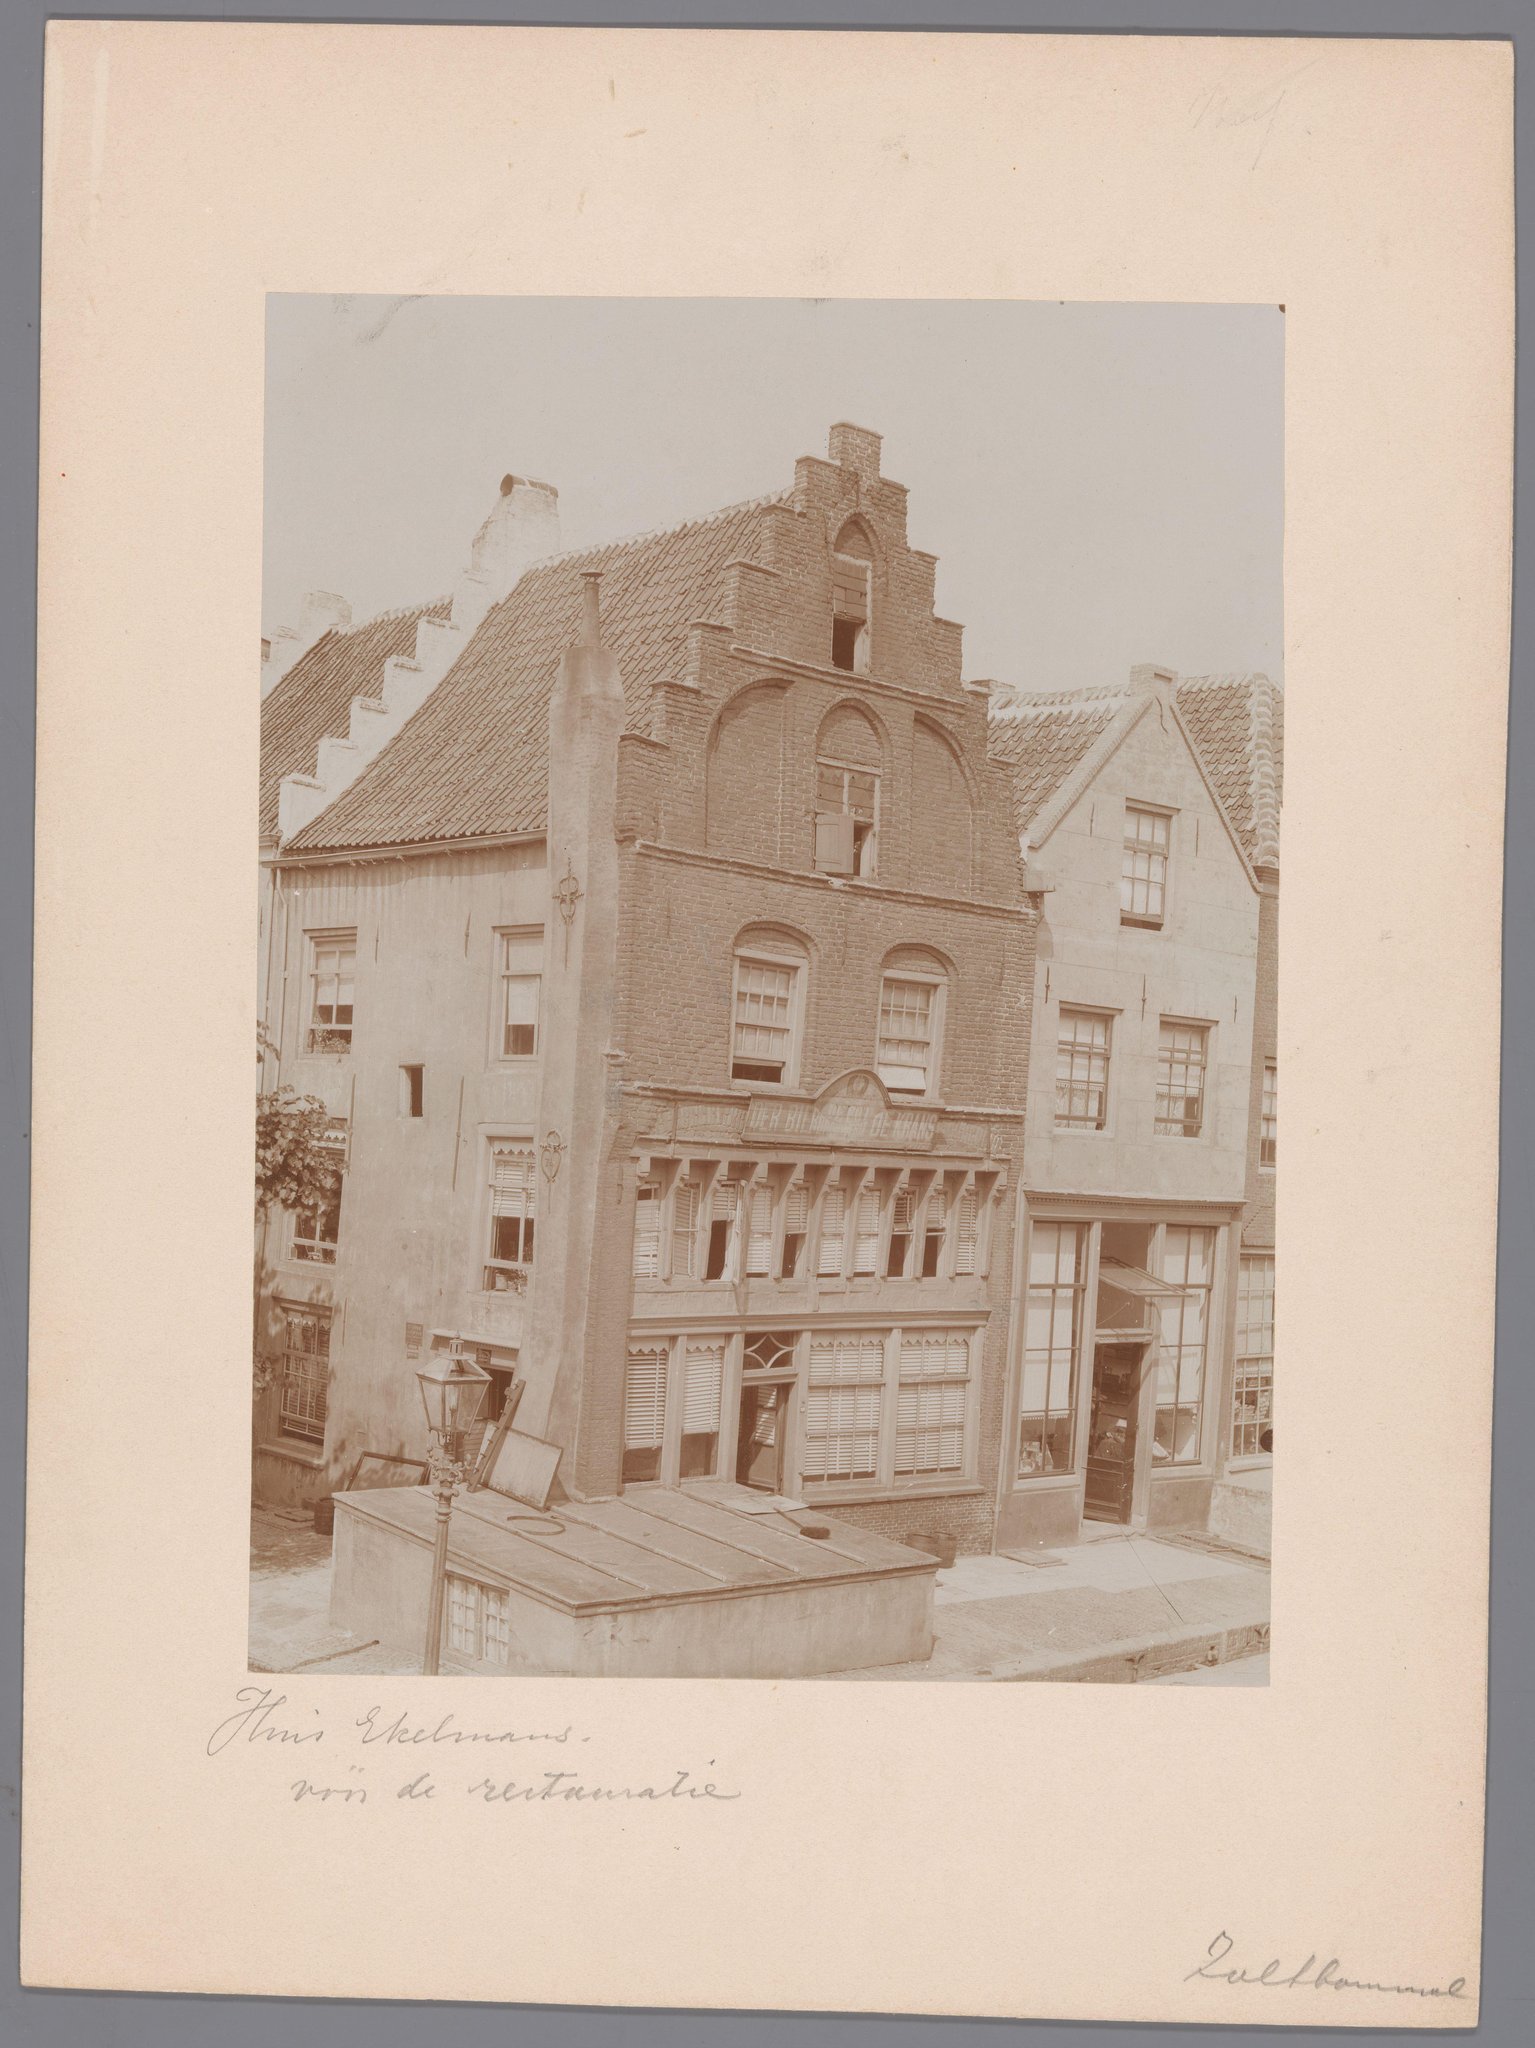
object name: photograph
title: Façade van huis Ekelmans te Zaltbommel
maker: anoniem (monumentenzorg)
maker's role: fotograaf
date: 1890-1920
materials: cardboard, photographic support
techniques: collodion silver print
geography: zaltbommel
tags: urban housing, façade (of house or building)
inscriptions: annotation: ‘Zalt Bommel (G.)/ Huis Ekelmans voor de restauratie’, annotation: ‘Huis Ekelmans/ voor de restauratie/ Zaltbommel’